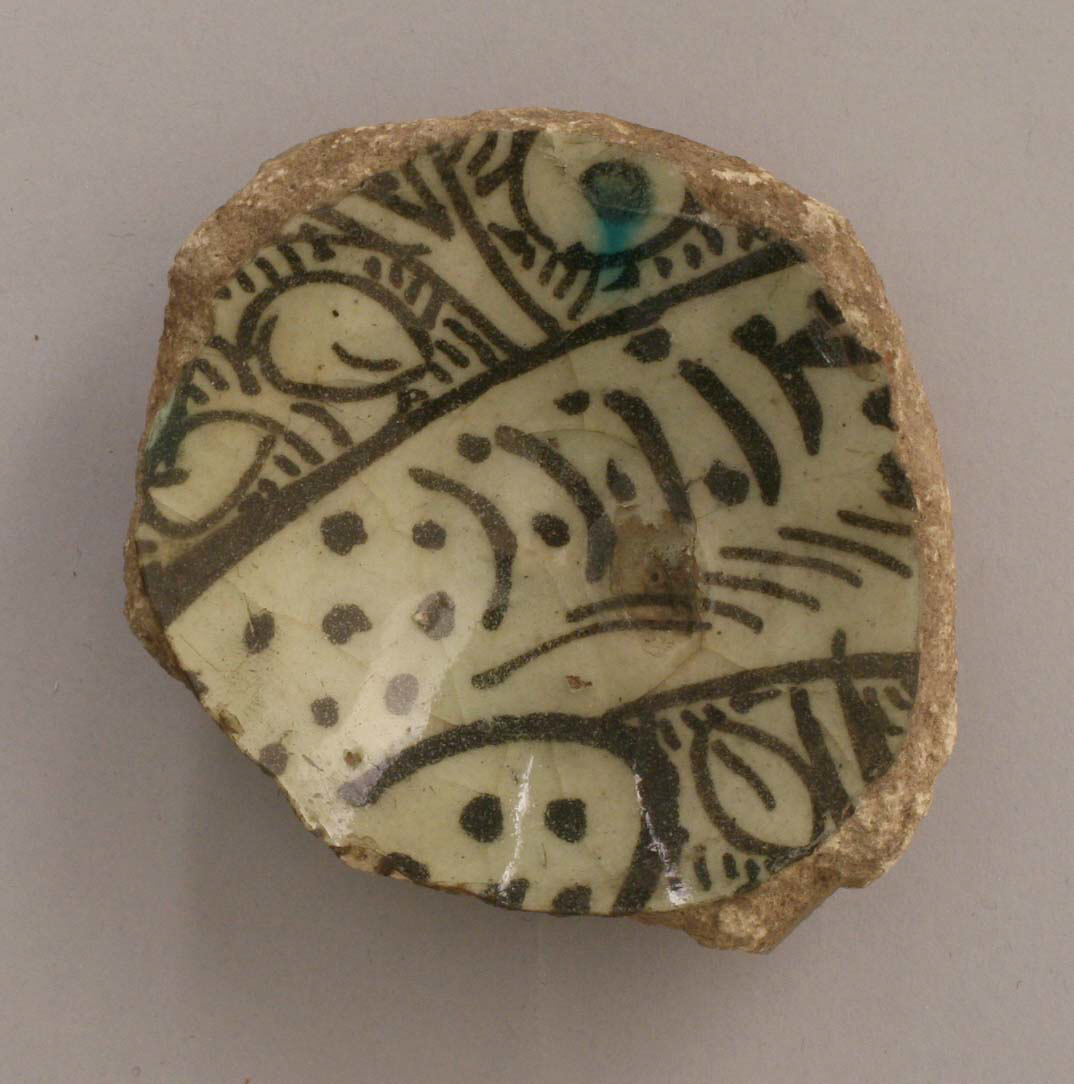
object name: fragment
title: Ceramic Fragment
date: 1301-1400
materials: glaze, stonepaste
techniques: painting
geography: syria